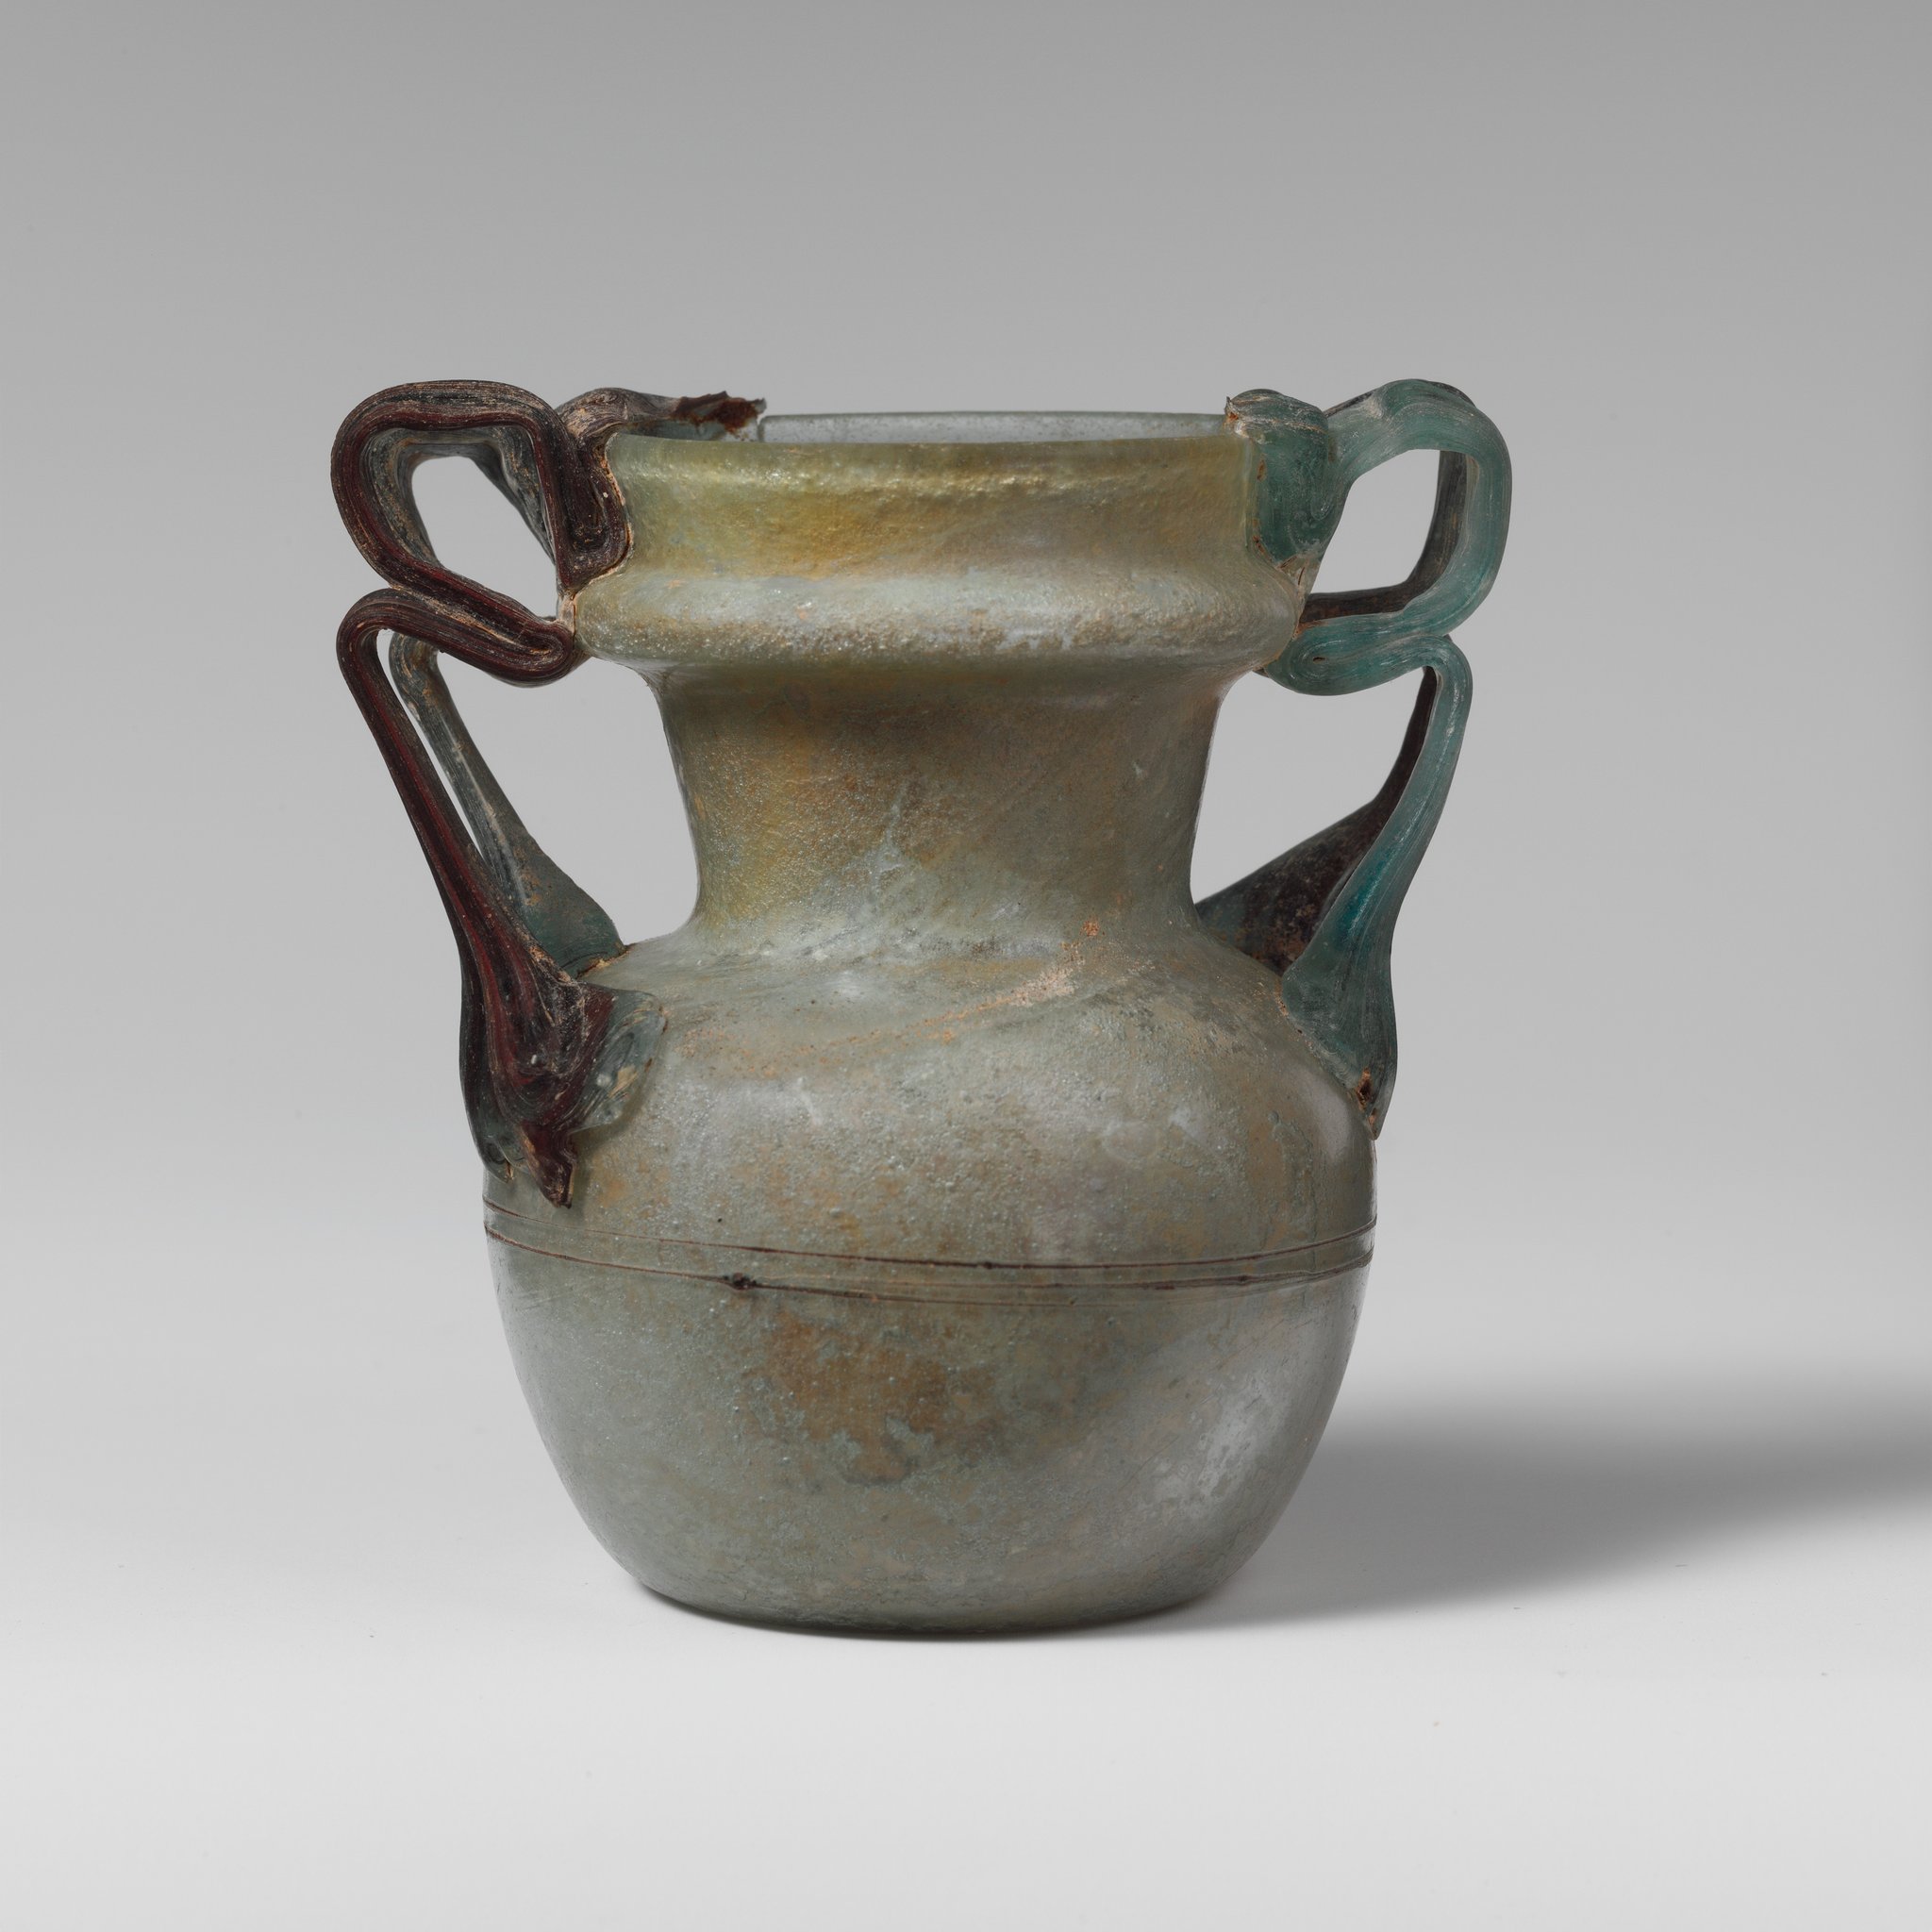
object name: jar, handled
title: Glass jar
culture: roman, syrian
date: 301-600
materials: glass